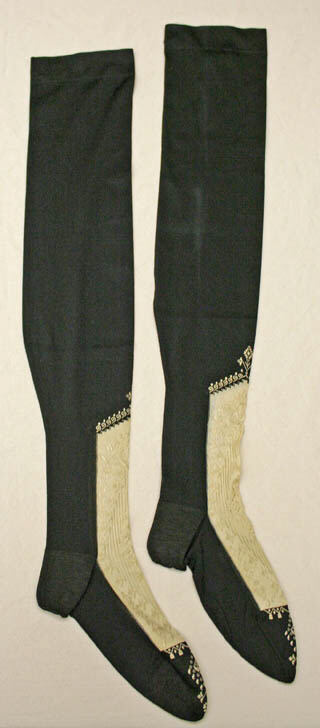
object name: stocking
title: Stockings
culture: french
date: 1883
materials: cotton